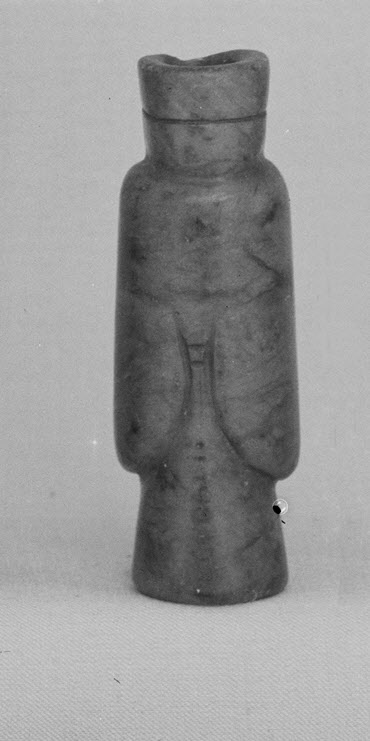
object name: mortuary figure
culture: chinese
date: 206 BCE-220 CE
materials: jade